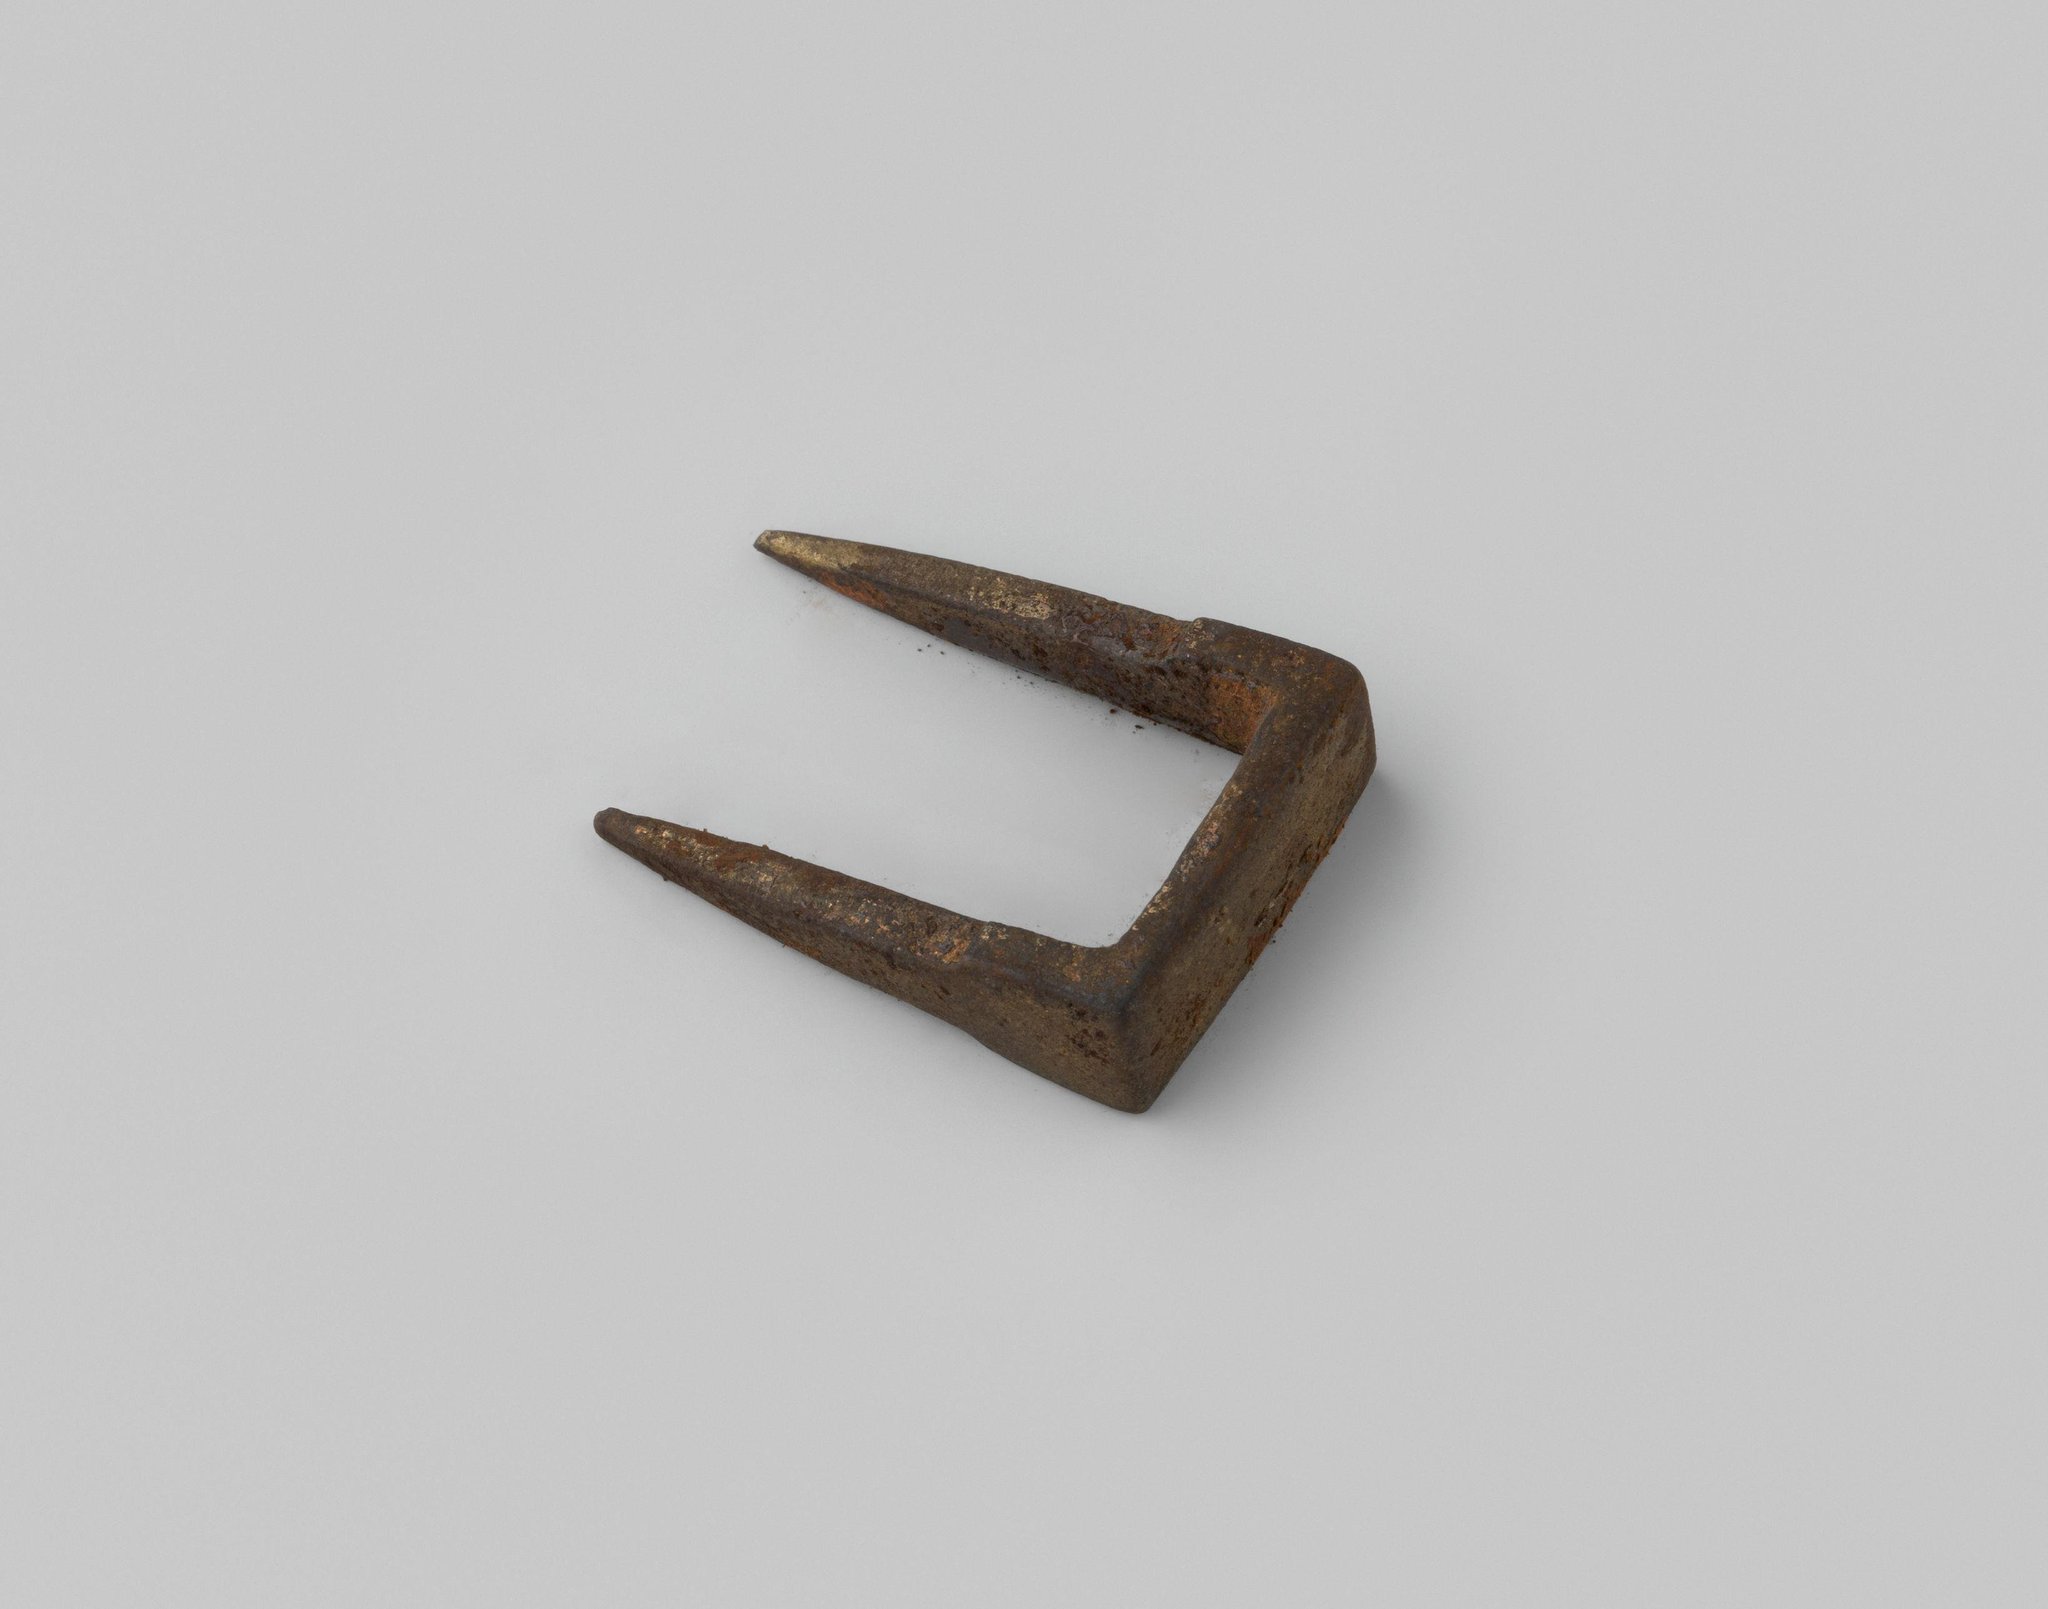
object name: kram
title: Kram afkomstig uit het wrak van de Oost-Indiëvaarder Hollandia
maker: Anonymous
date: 1700-1743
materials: copper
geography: netherlands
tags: verenigde oostindische compagnie, hollandia (schip)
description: Staple; U-shaped, rectangular, flat upper part, both vertical sides pointed.